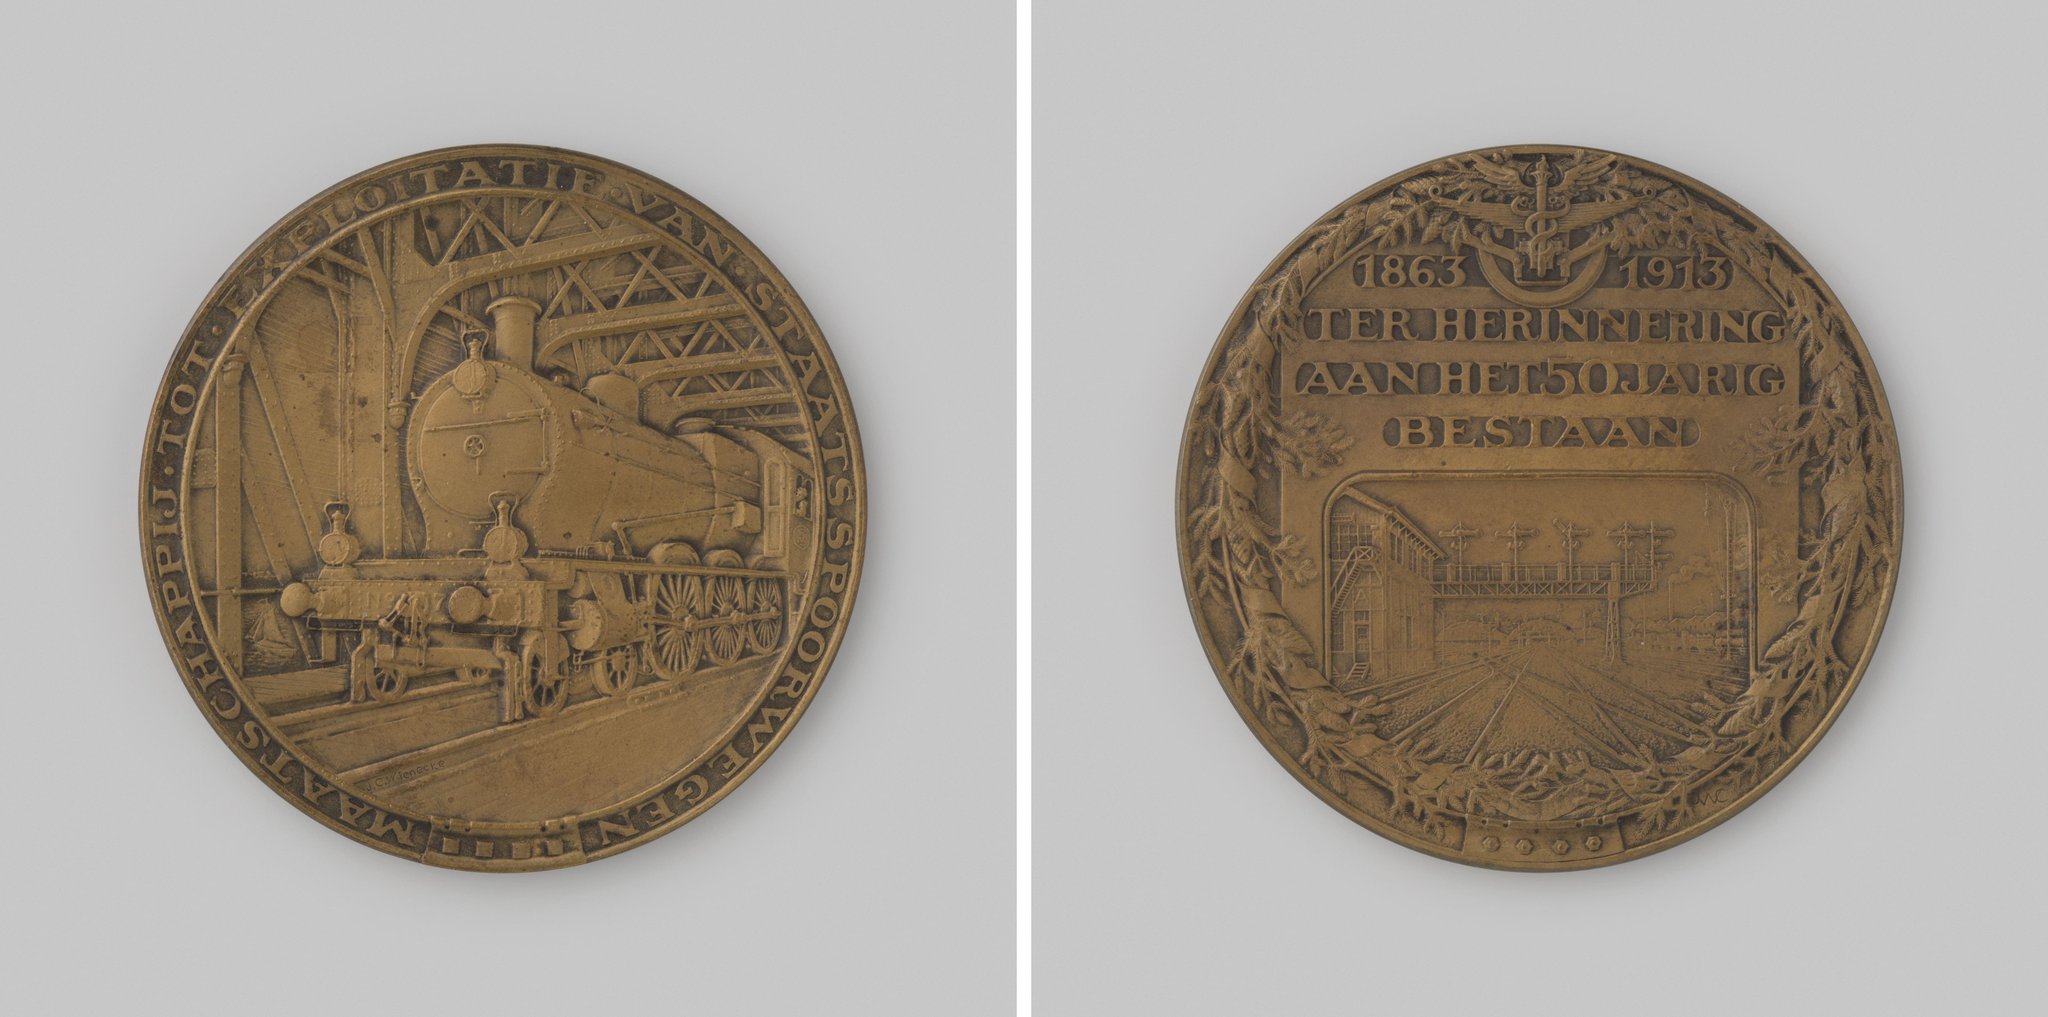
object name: history medal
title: Vijftigjarig bestaan van de Maatschappij tot Exploitatie van Staatsspoorwegen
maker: johannes cornelis wienecke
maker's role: medailleur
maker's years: 1872-1945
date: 1913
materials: bronze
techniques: striking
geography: netherlands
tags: steam locomotive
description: Vijftigjarig bestaan van de Maatschappij tot Exploitatie van Staatsspoorwegen. Bronzen penning, voorzijde: stoomlocomotief op spoorbrug binnen omschrift; keerzijde: gezicht op spooremplacement met seinhuis, waarboven vierregelige tekst, binnen krans.